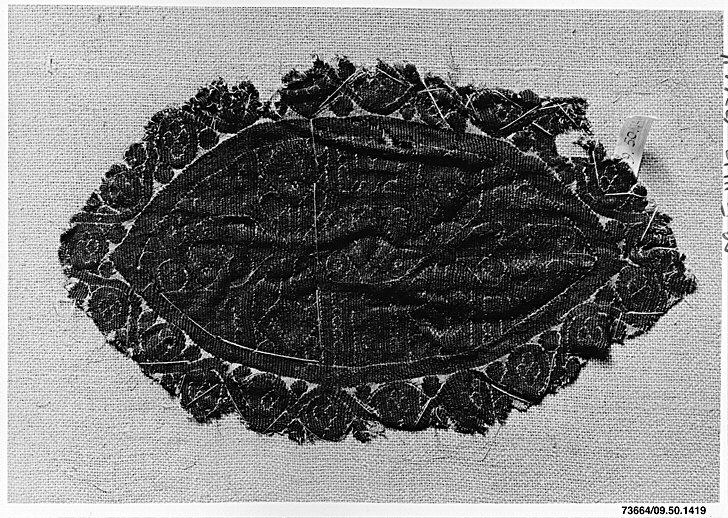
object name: panel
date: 301-500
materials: linen, wool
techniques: weave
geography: egypt